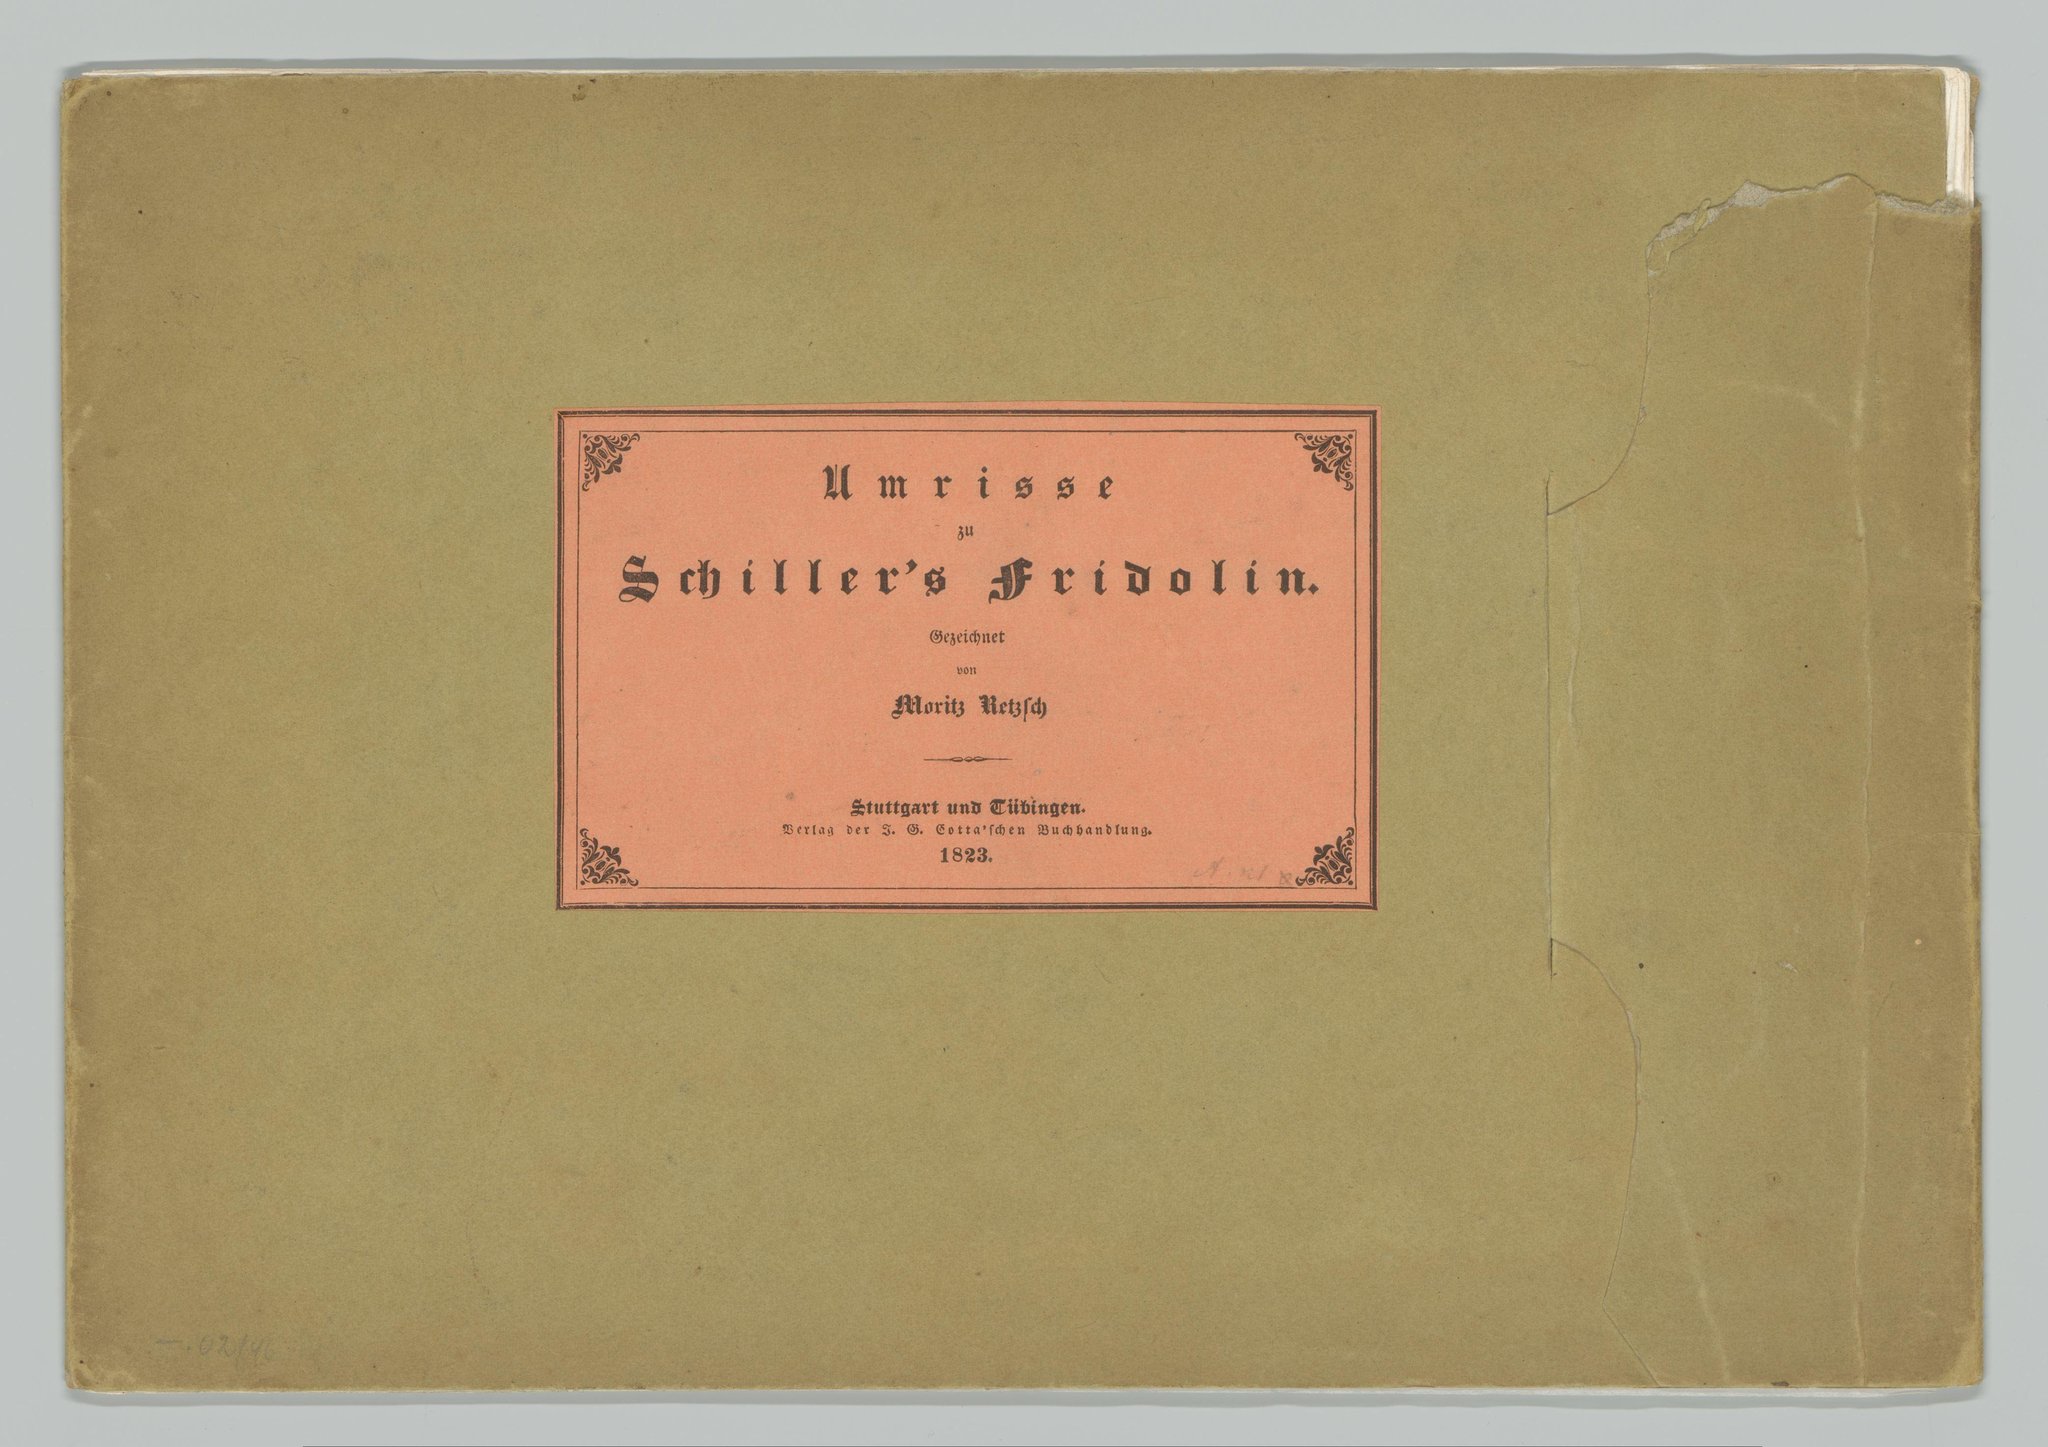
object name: print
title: Omslag voor prentserie Schiller's Fridolin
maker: moritz retzsch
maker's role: print maker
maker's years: 1779-1857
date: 1823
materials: paper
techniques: etching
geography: tübingen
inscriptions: tekst, verso, opgeplakt: Lijst met plaatsen waar het gekocht kan worden en prijzen